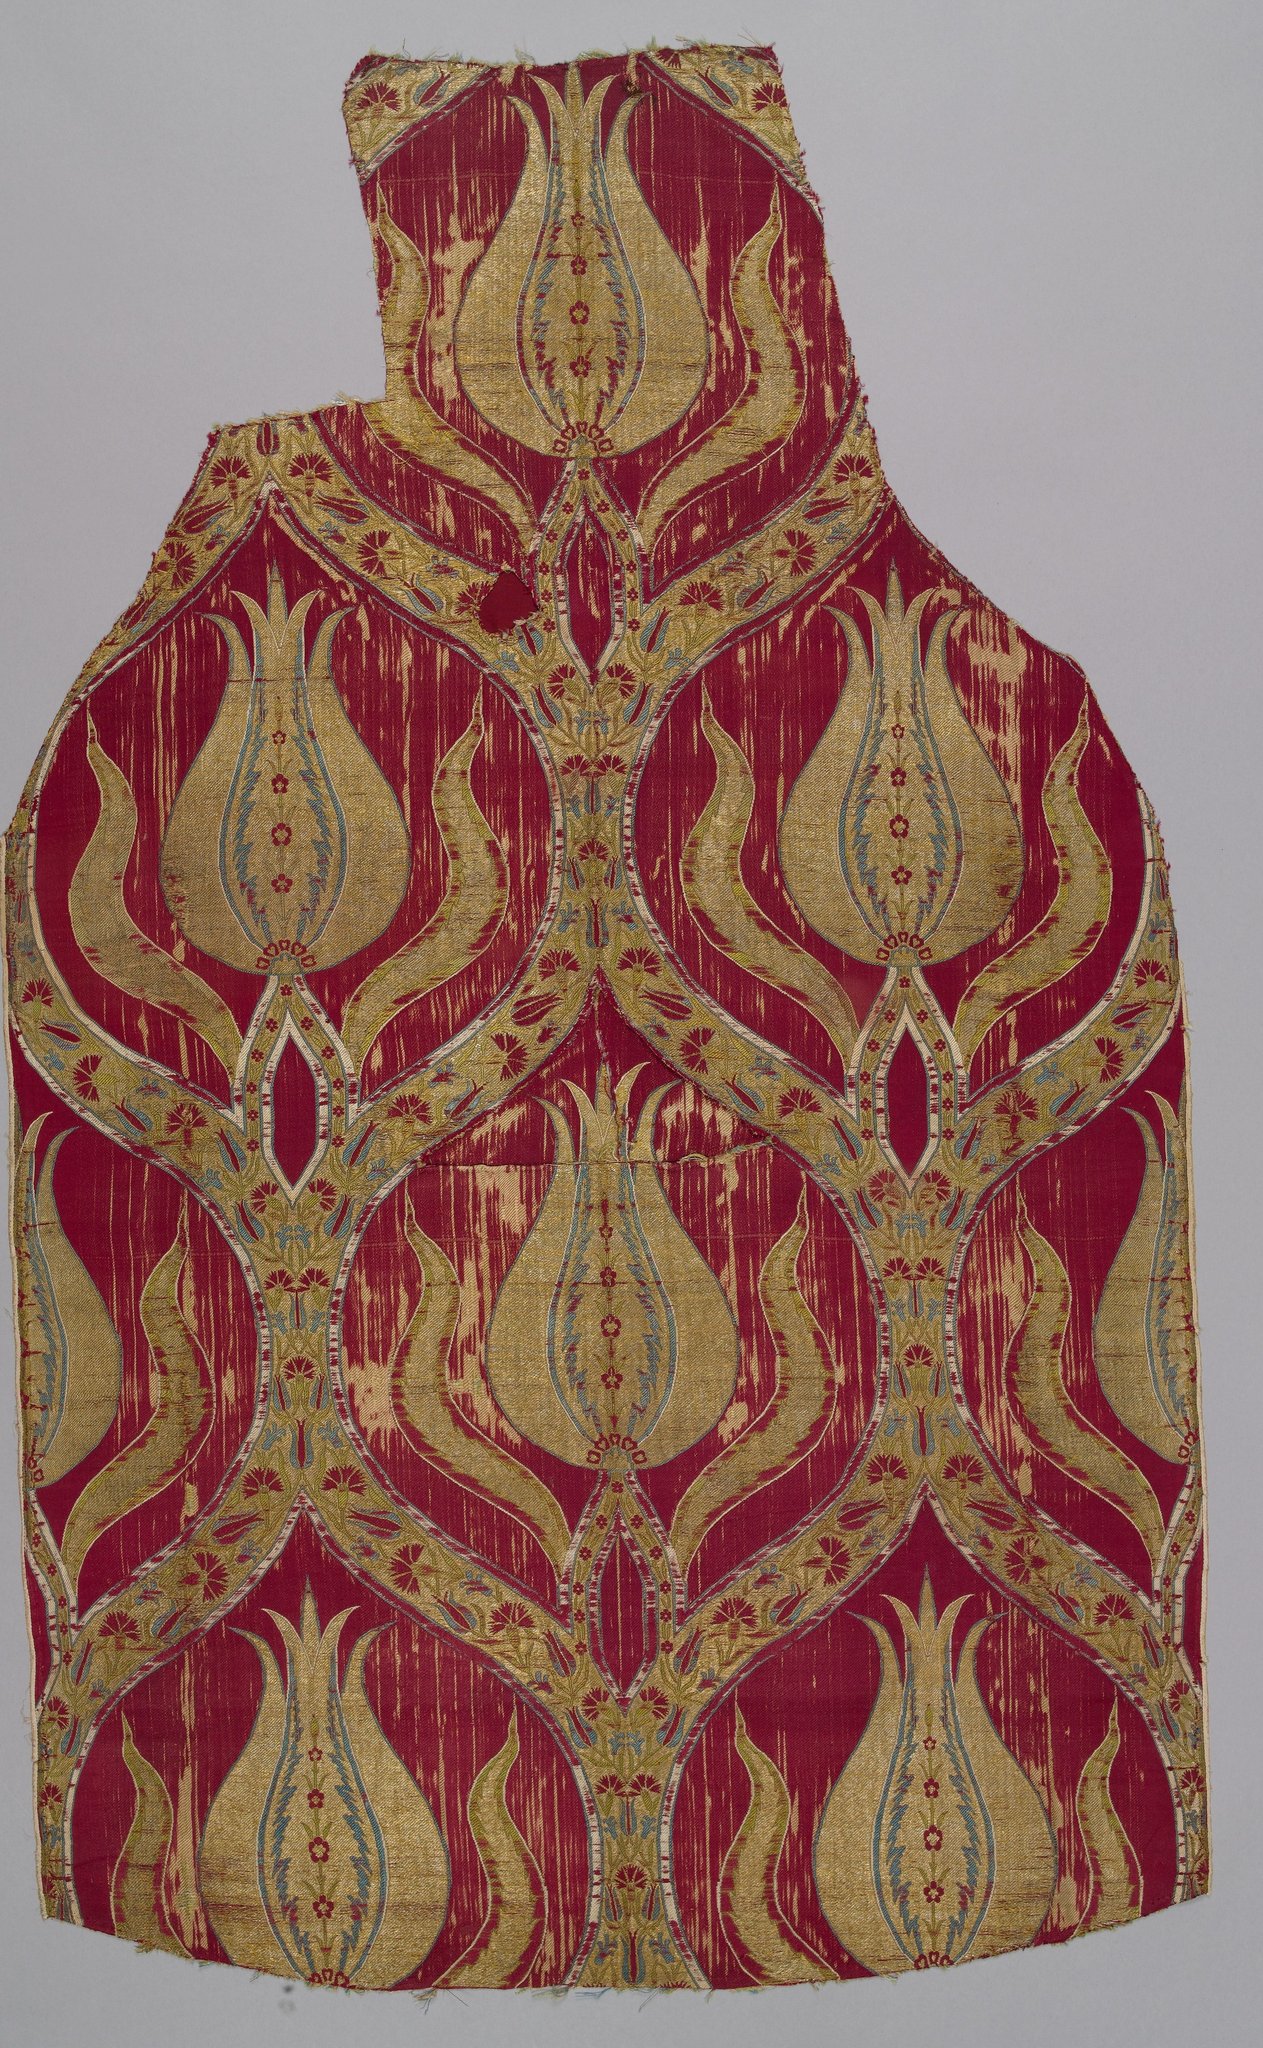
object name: textile fragment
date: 1501-1600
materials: metal thread, silk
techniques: lampas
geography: turkey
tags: tulips